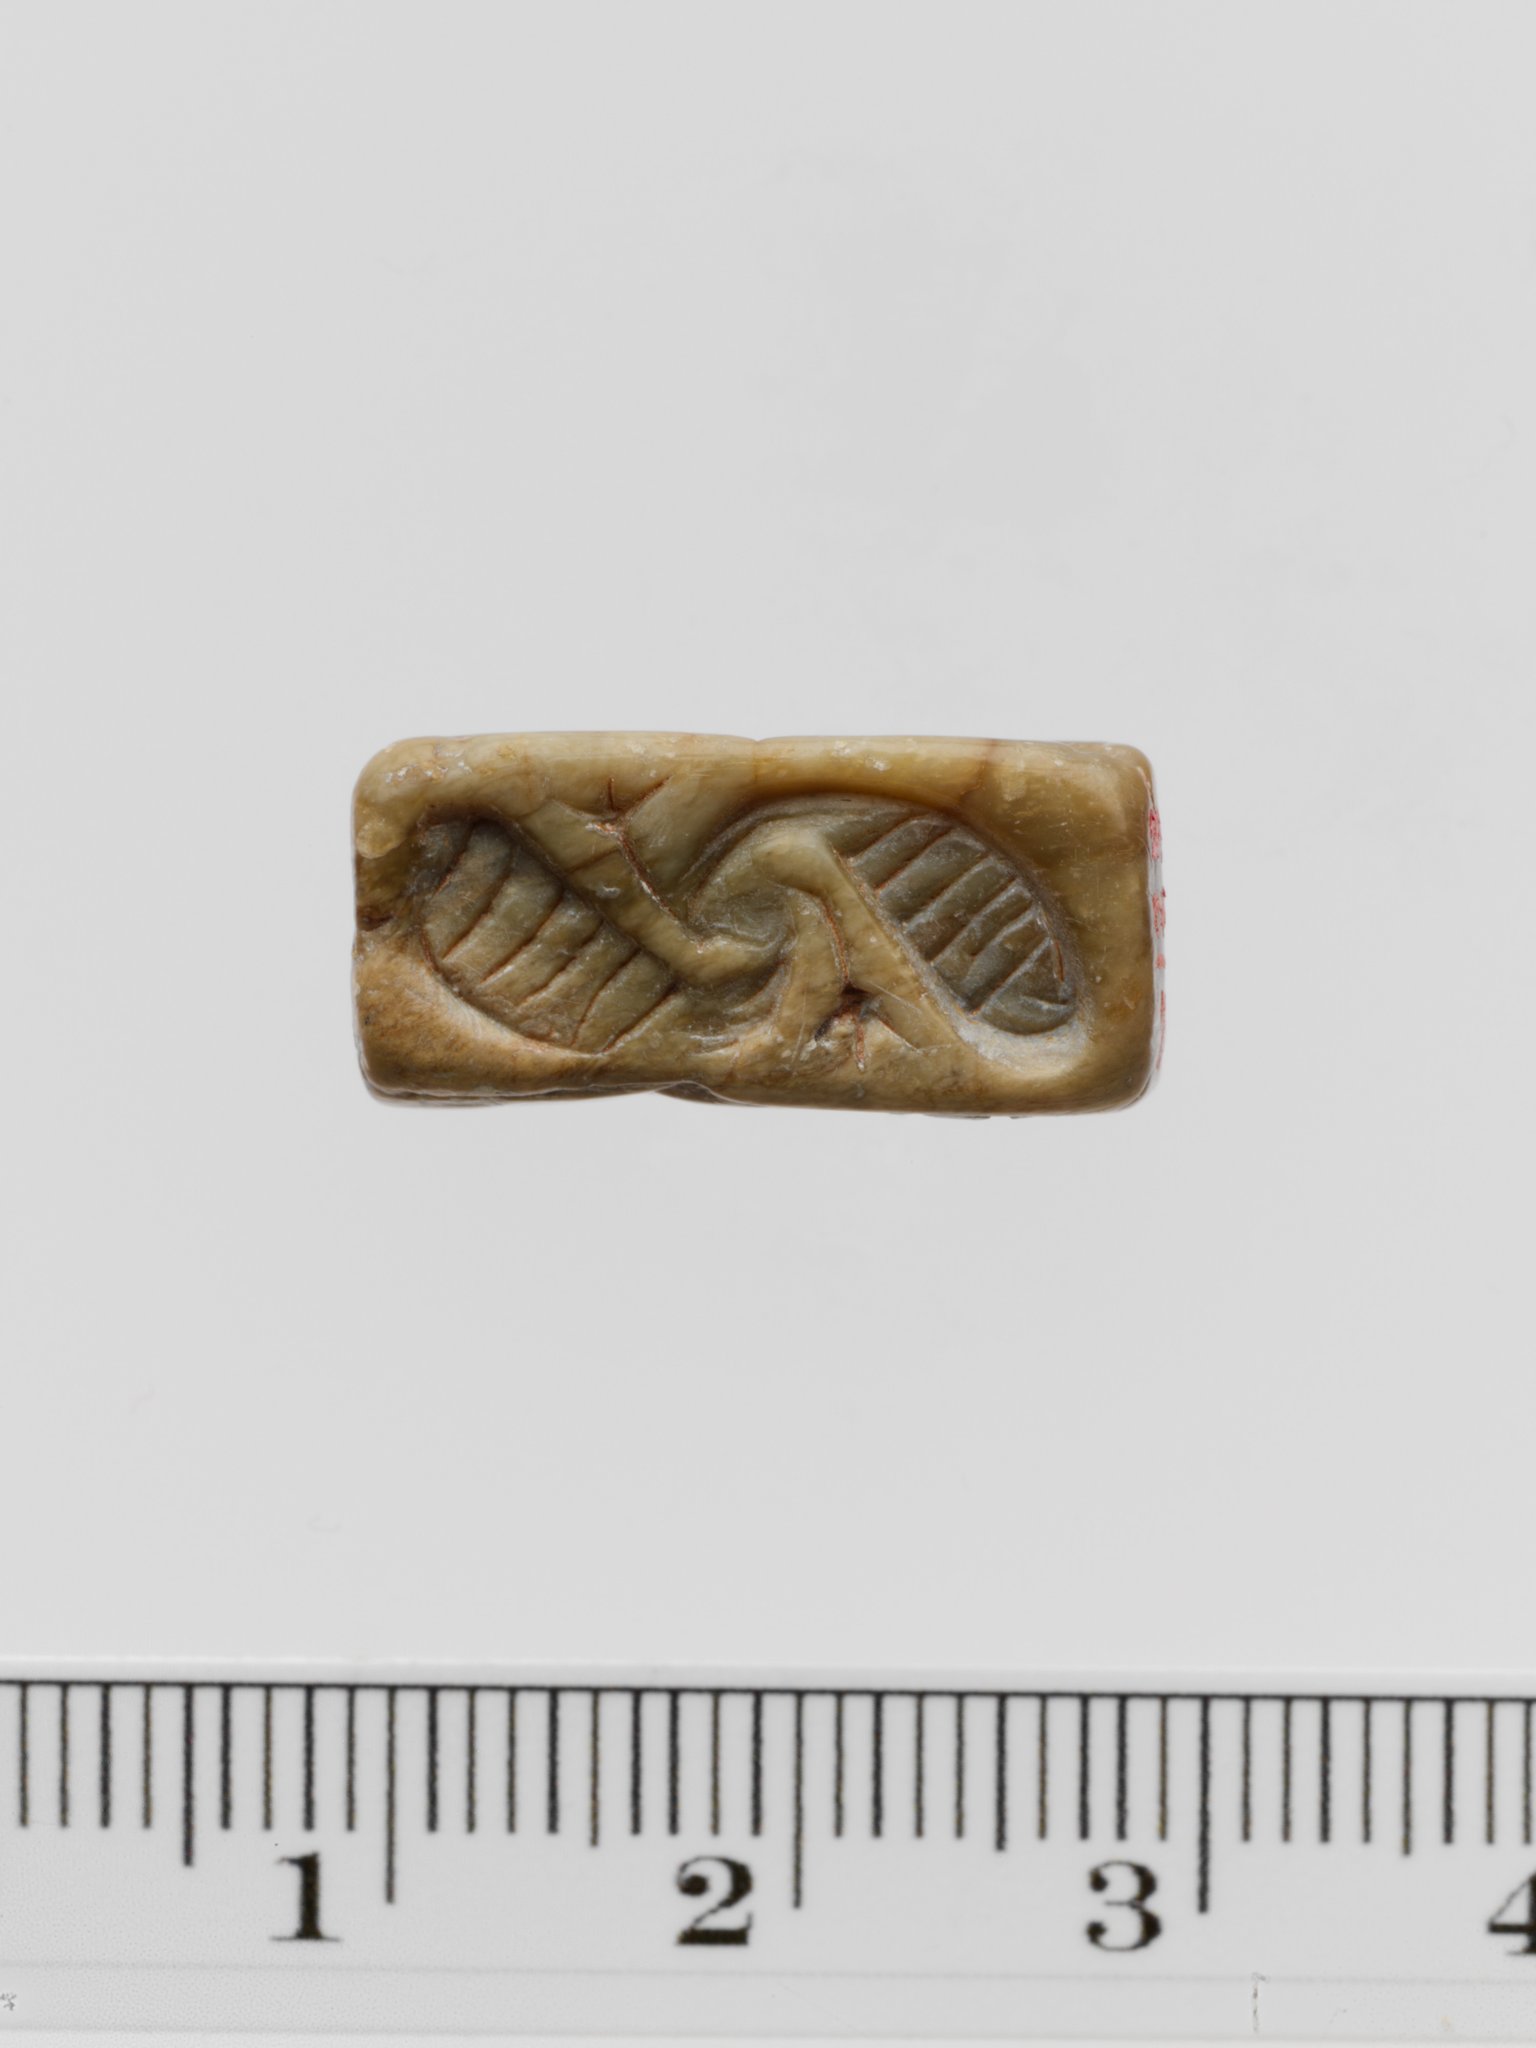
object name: seal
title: Steatite rectangular prism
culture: minoan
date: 1900-1750 BCE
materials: stone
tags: men,hieroglyphs,leaves